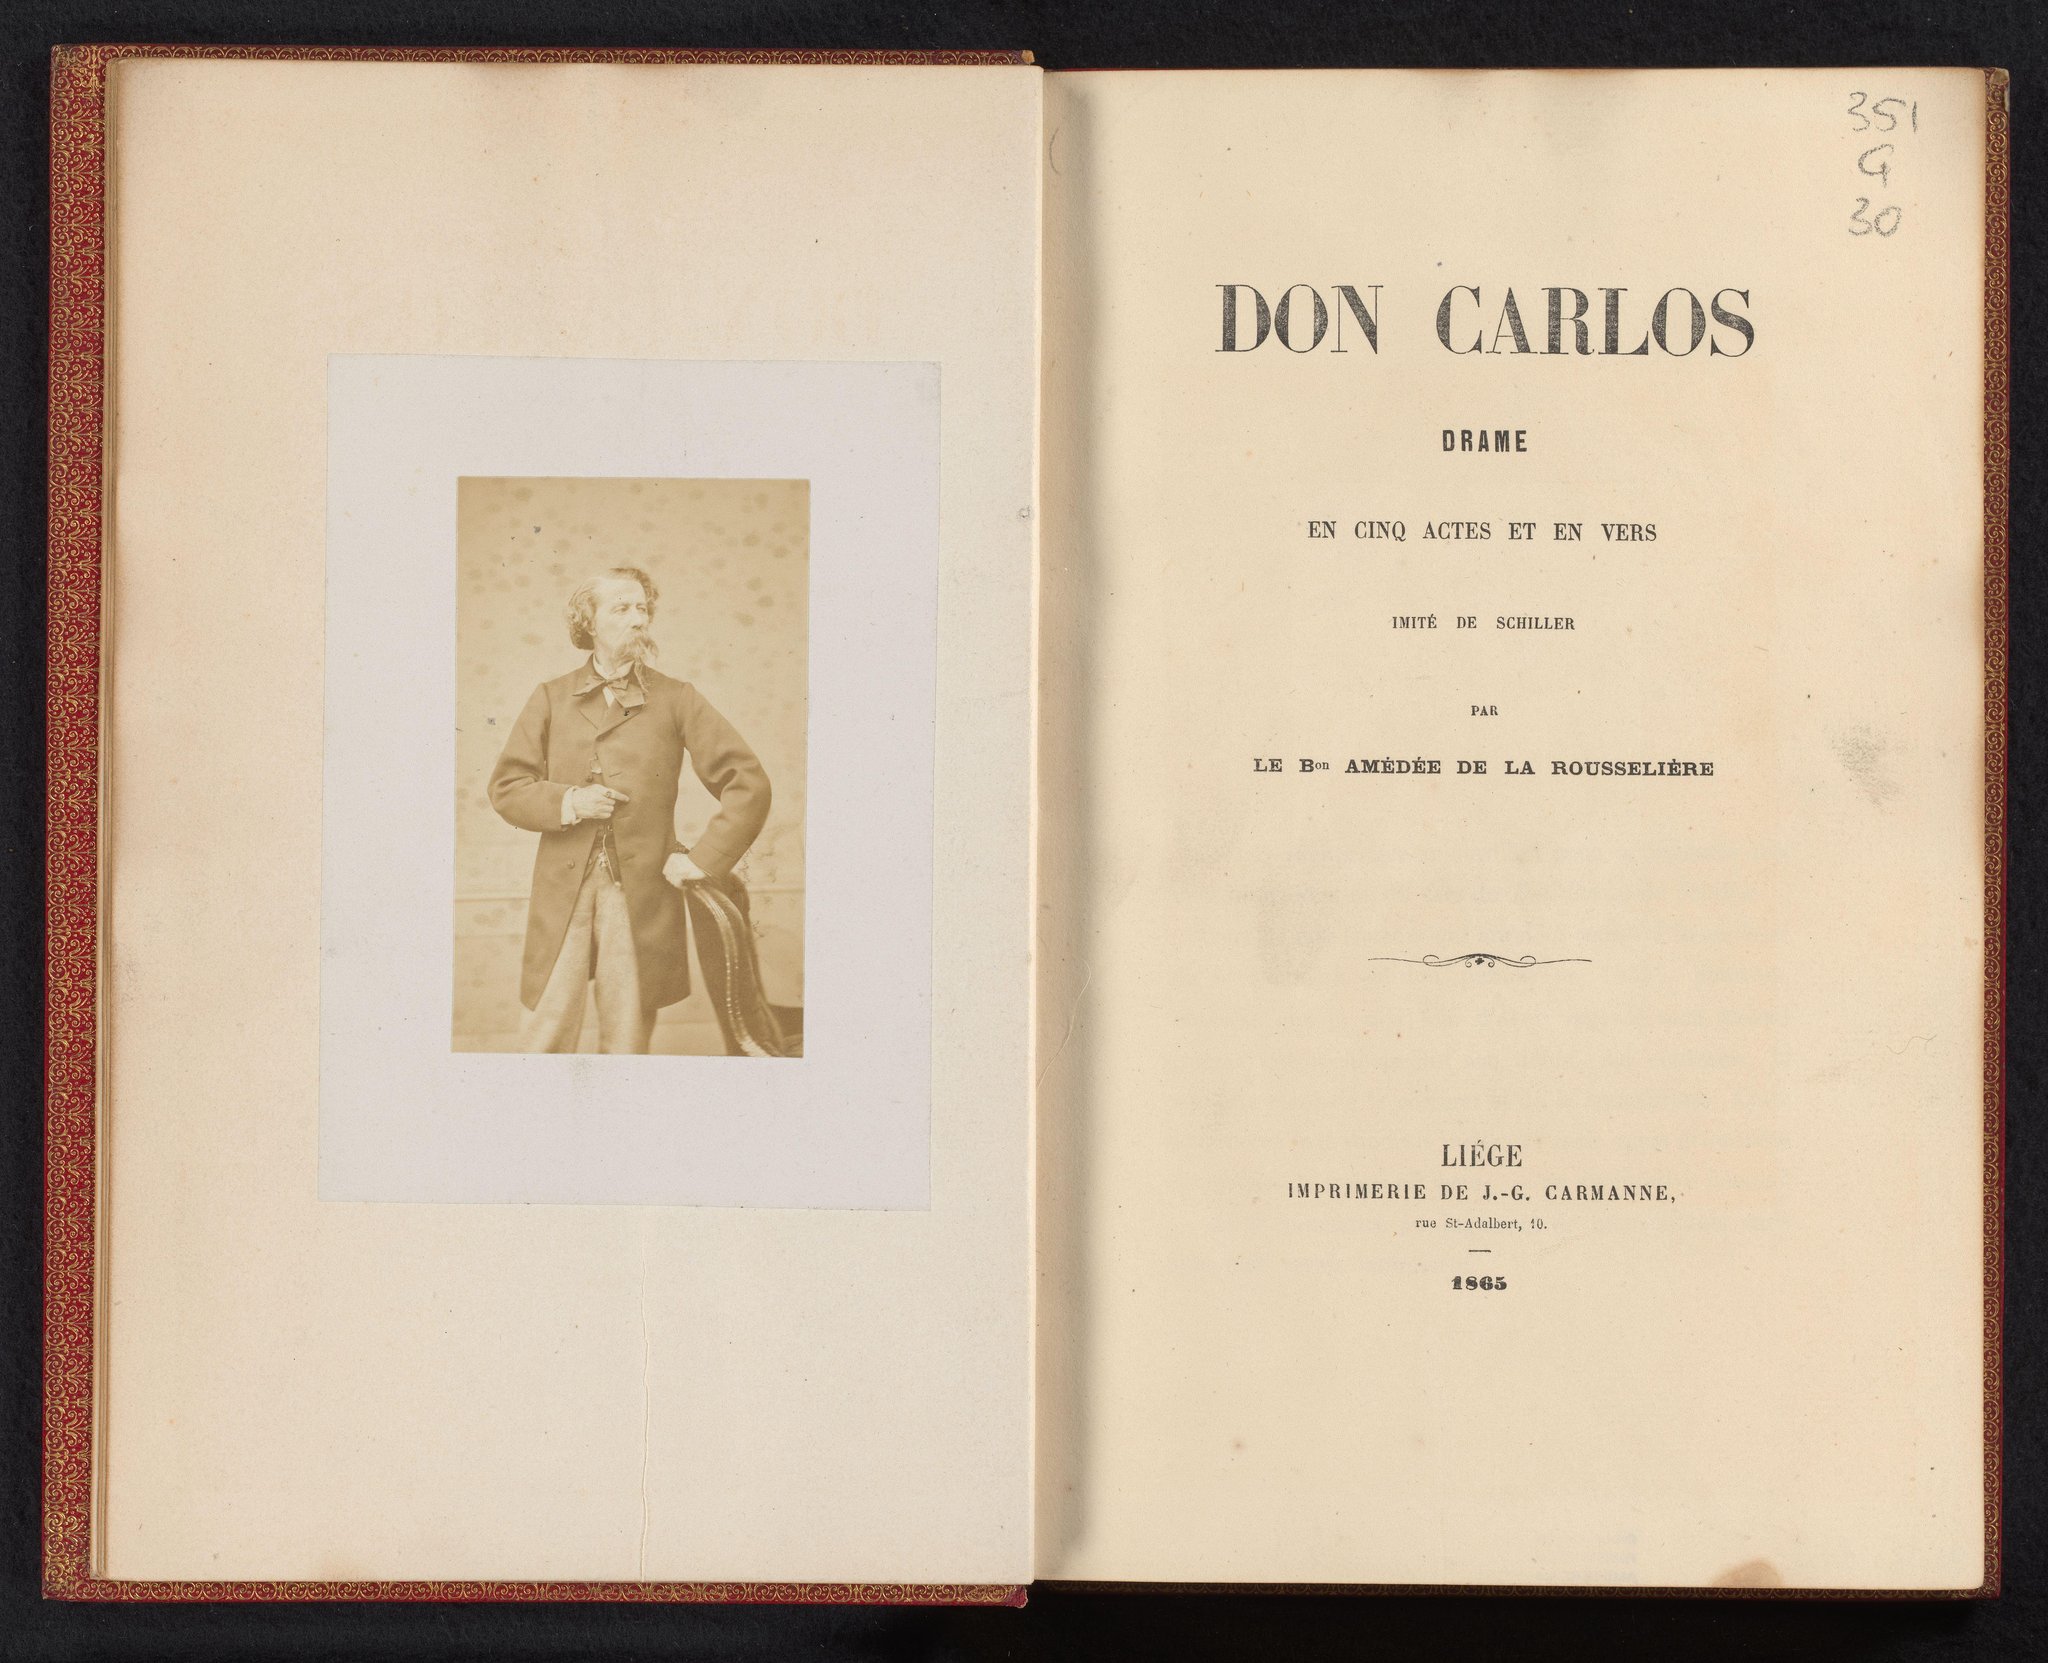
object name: page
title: Portret van François-Eustache de la Rousselière Clouard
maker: Anonymous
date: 1860-1865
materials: paper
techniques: albumen print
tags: london, françois-eustache de la rousselière clouard, historical persons